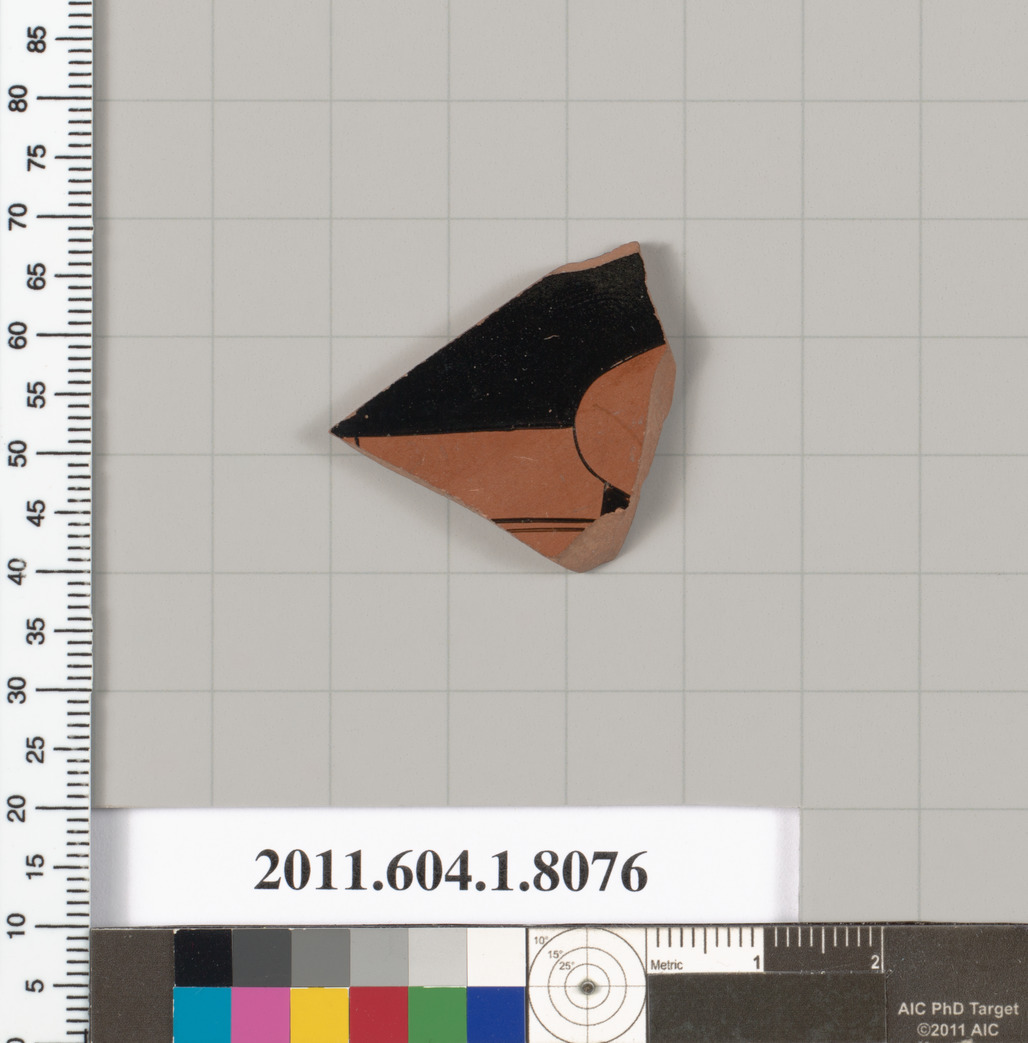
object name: kylix fragment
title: Terracotta fragment of a kylix (drinking cup)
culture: greek, attic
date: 510-500 BCE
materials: terracotta